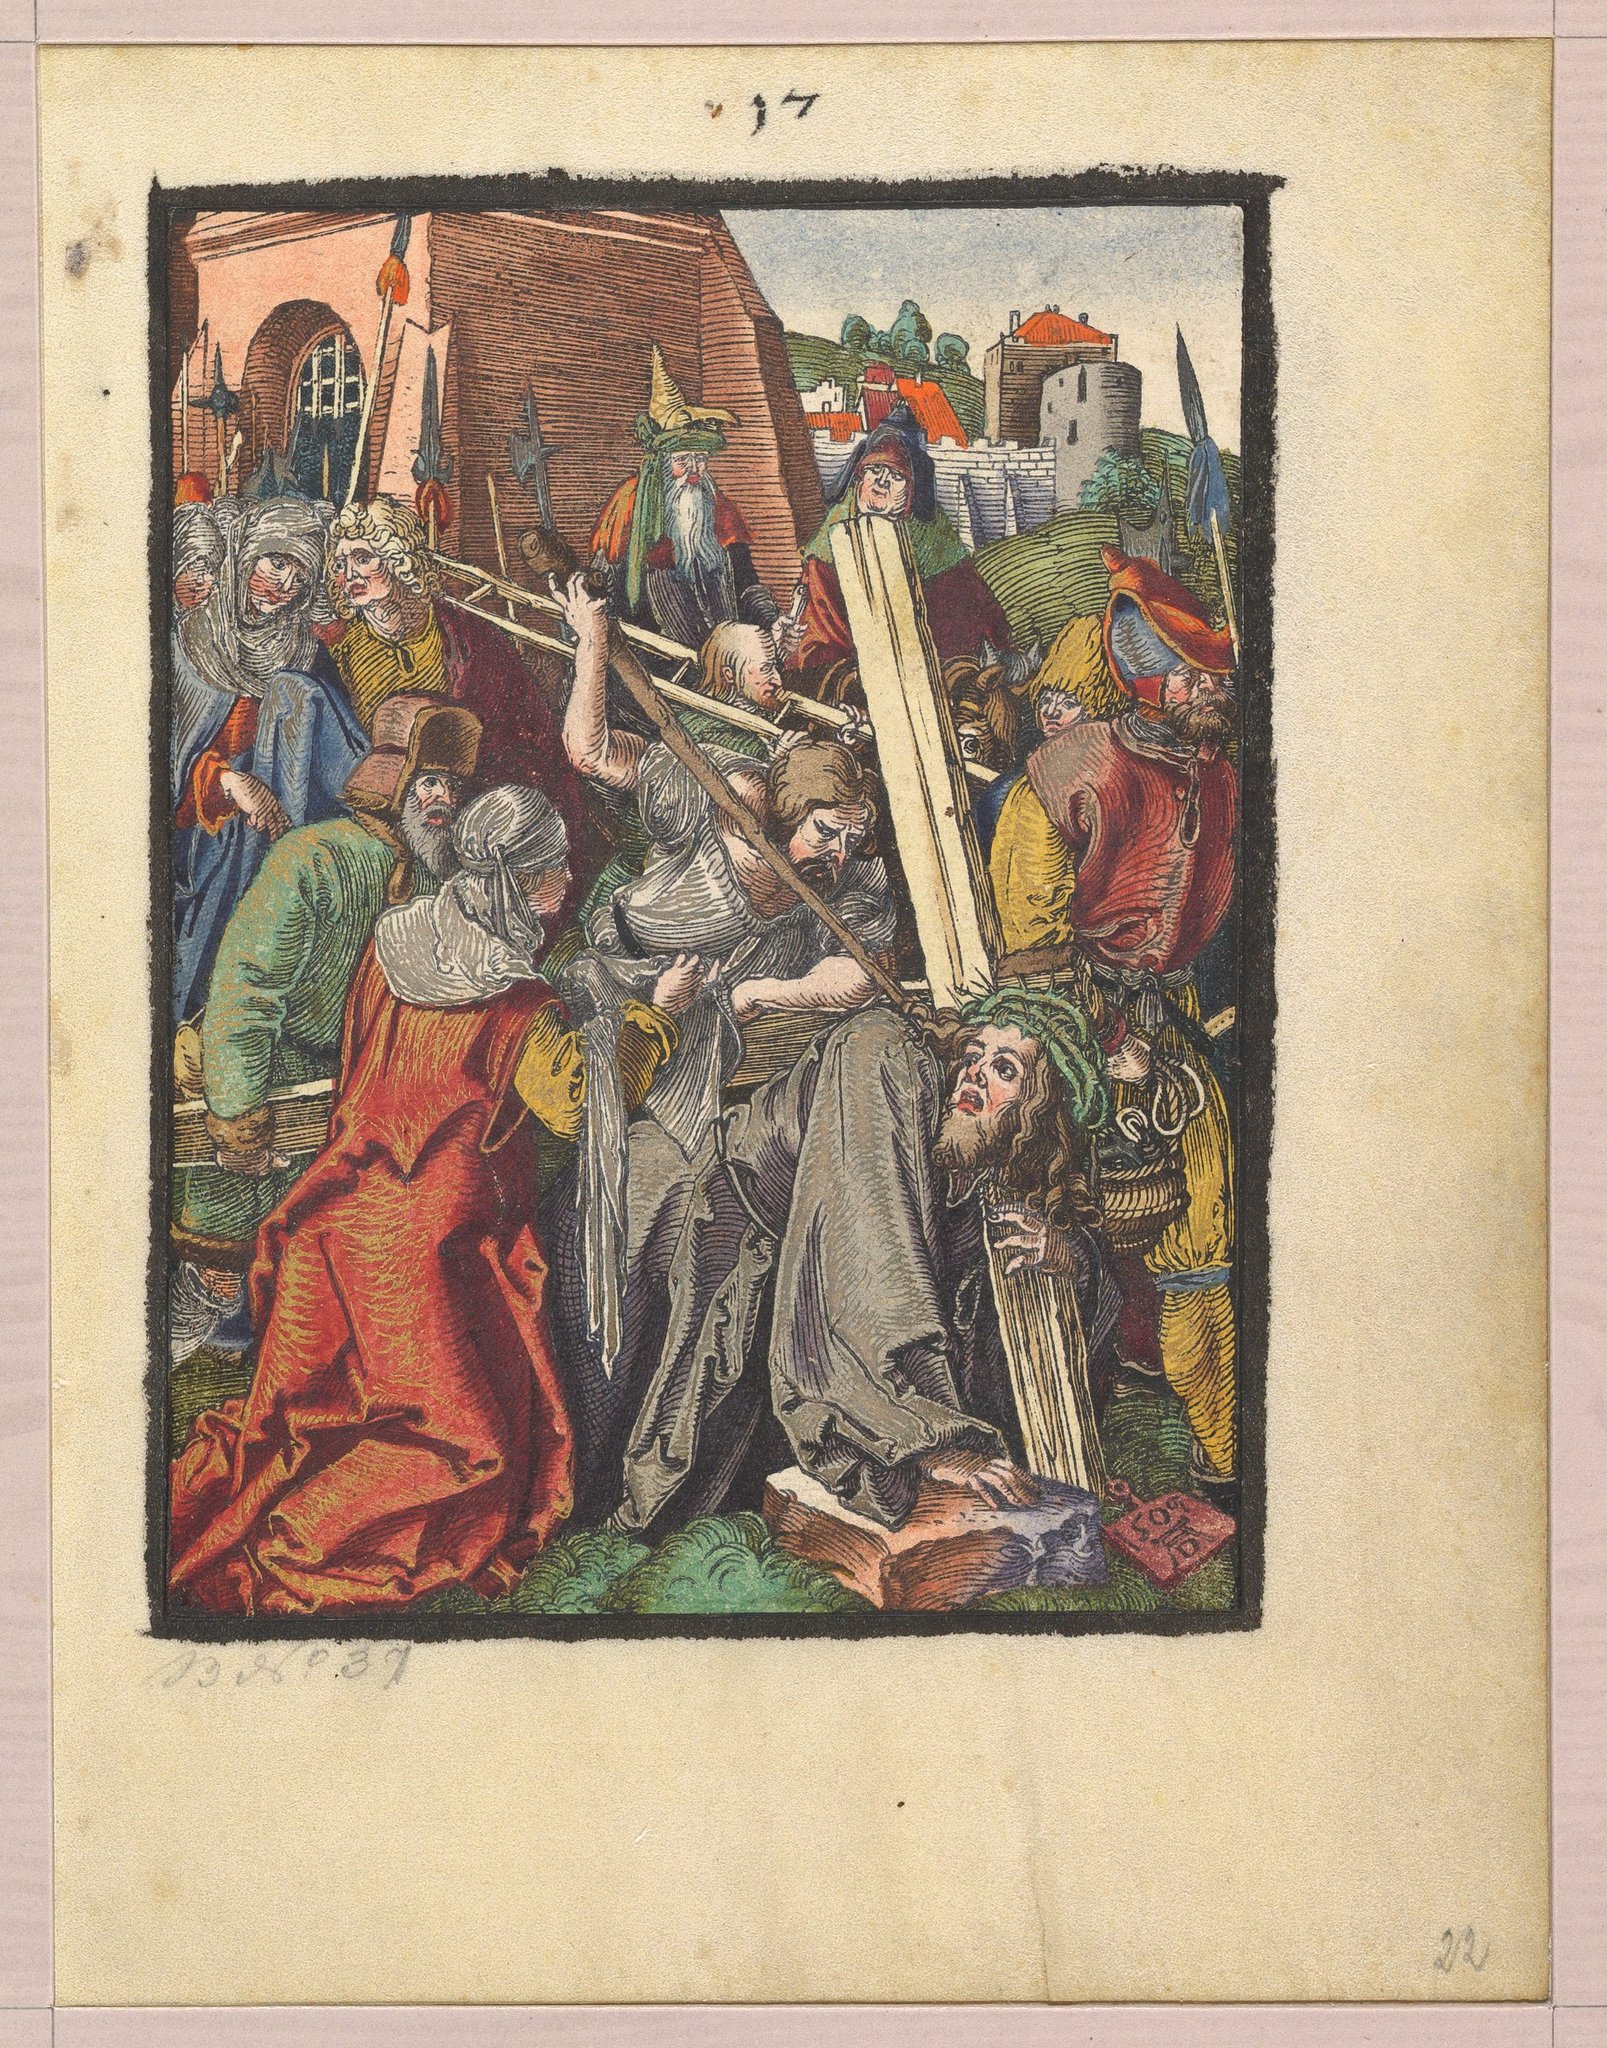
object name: print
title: Small Woodcut Passion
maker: albrecht dürer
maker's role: artist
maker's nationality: german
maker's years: 1471-1528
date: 1509-1510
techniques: bookbinding, hand coloring, woodcut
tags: men,women,jesus